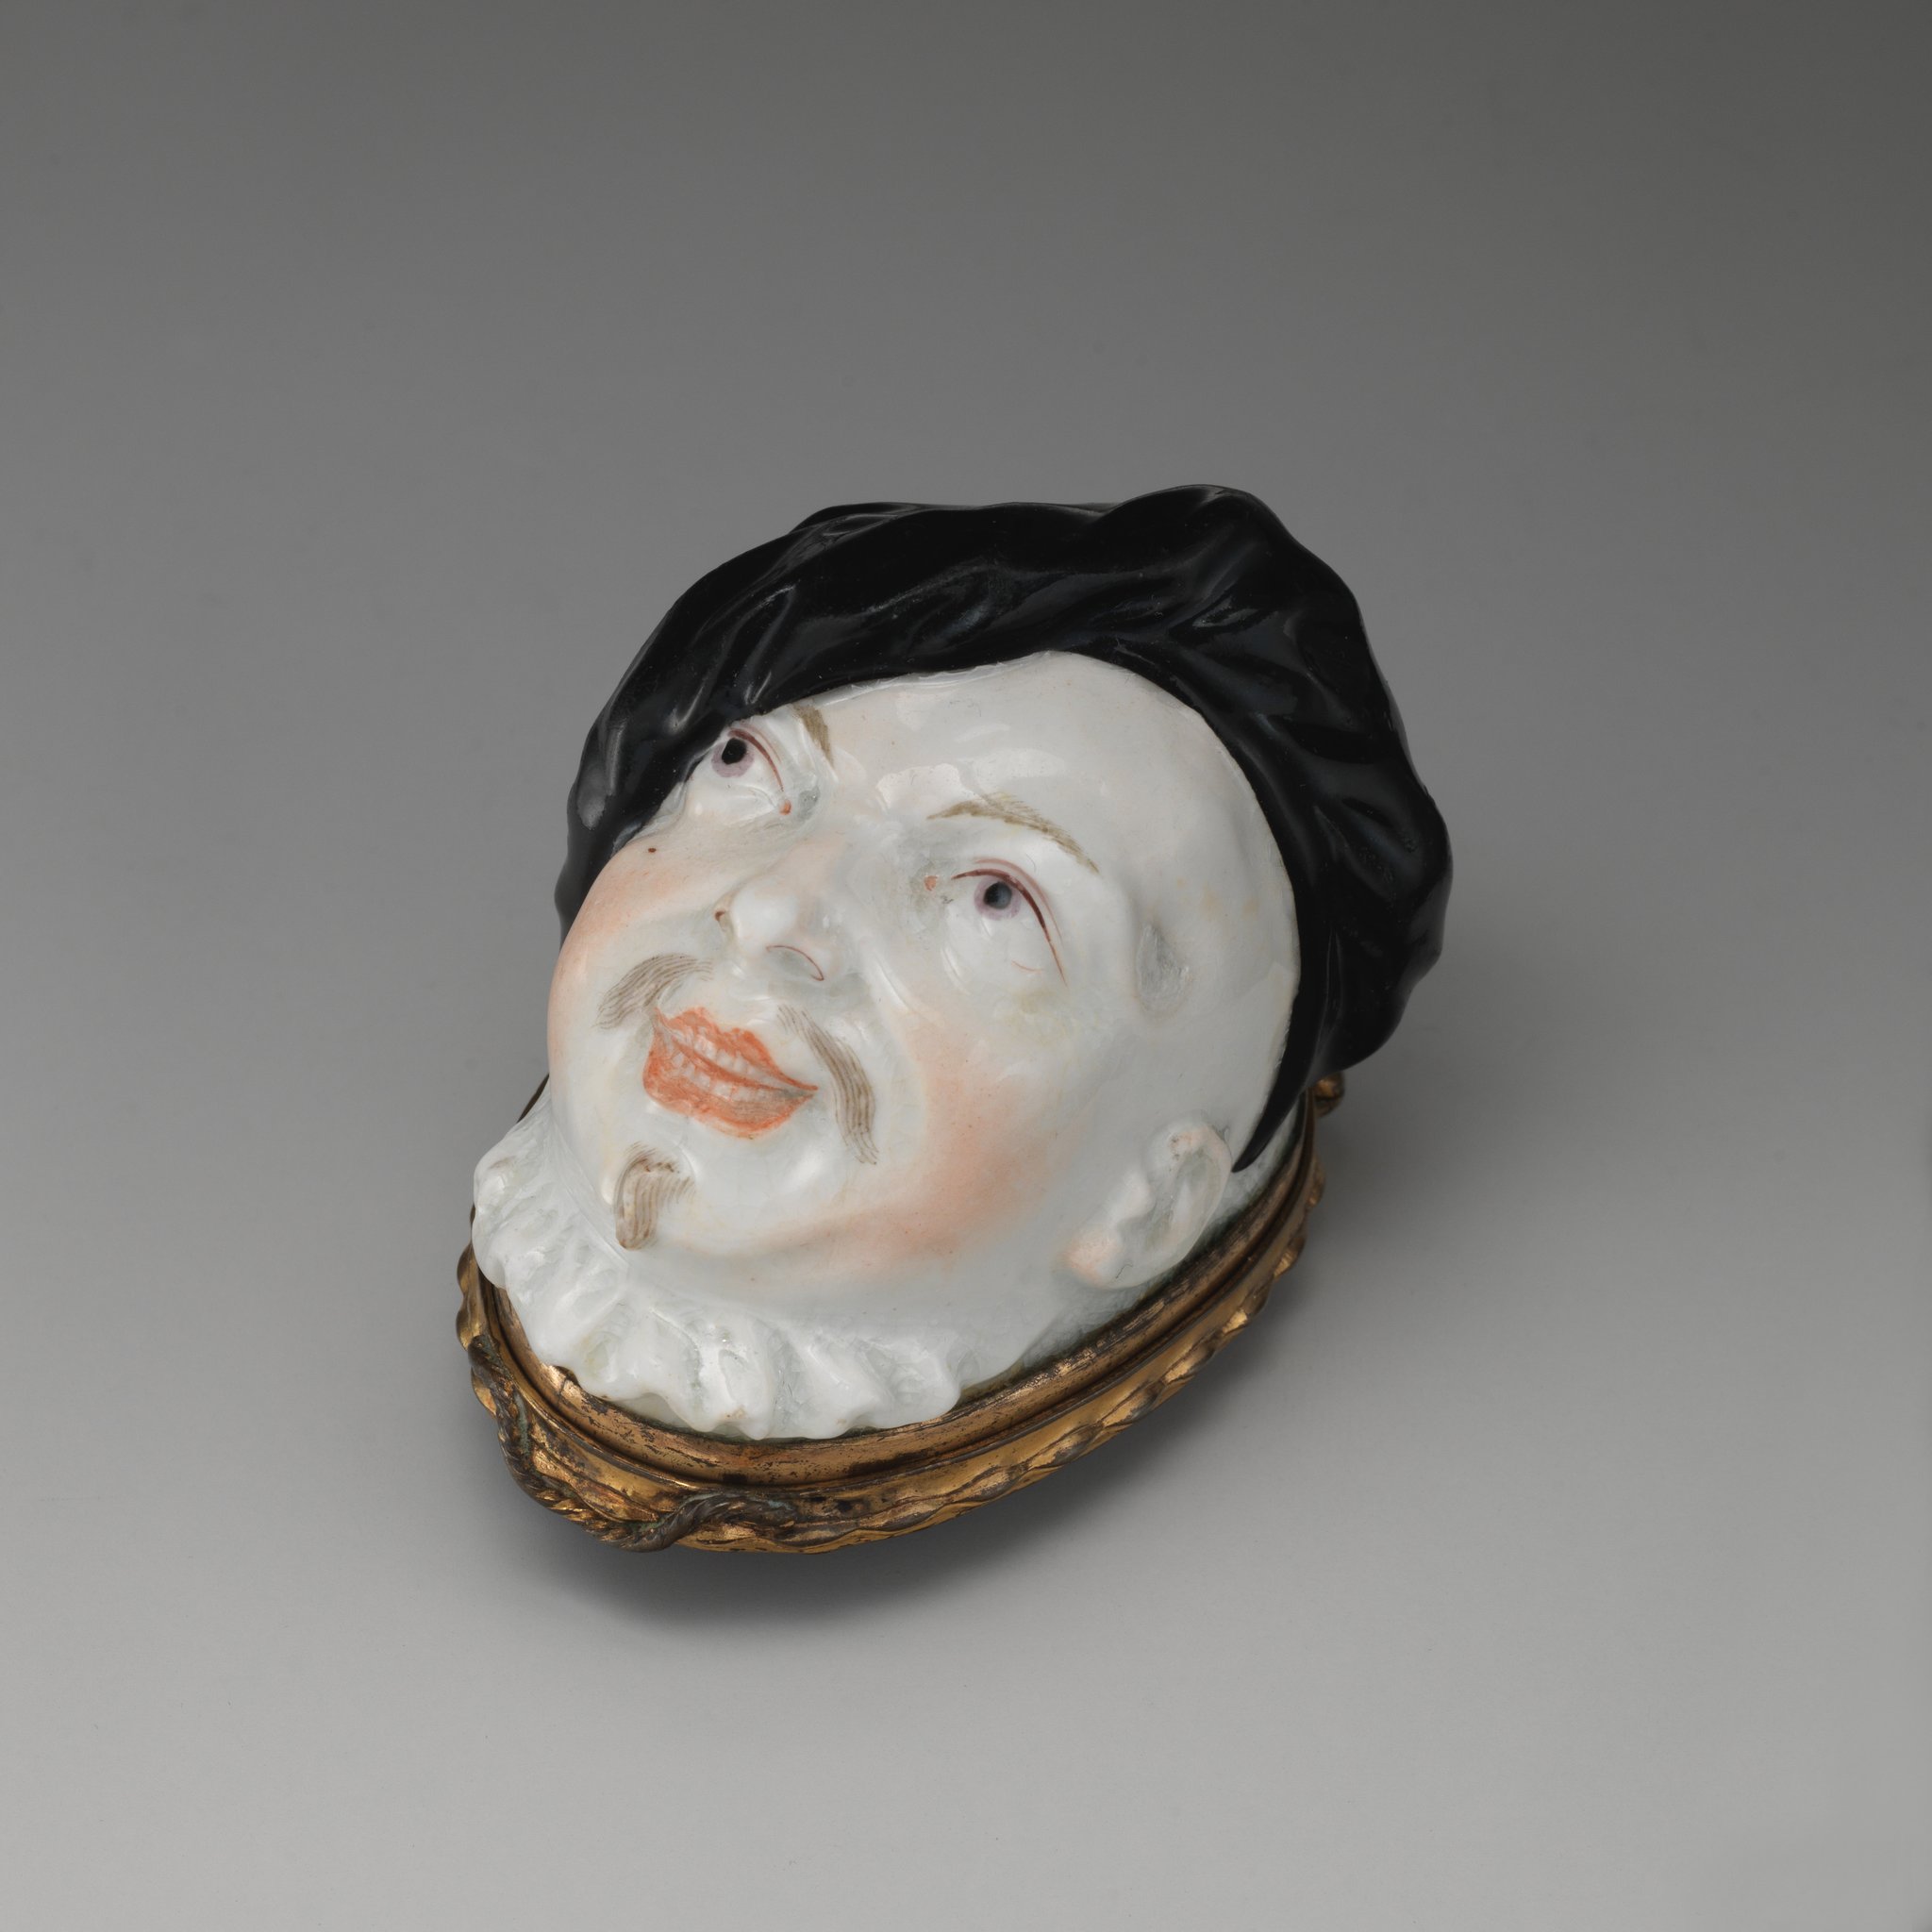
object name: toy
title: Man's head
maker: chelsea porcelain manufactory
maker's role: factory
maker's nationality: british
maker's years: 1744-1784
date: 1760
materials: soft paste porcelain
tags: heads,men